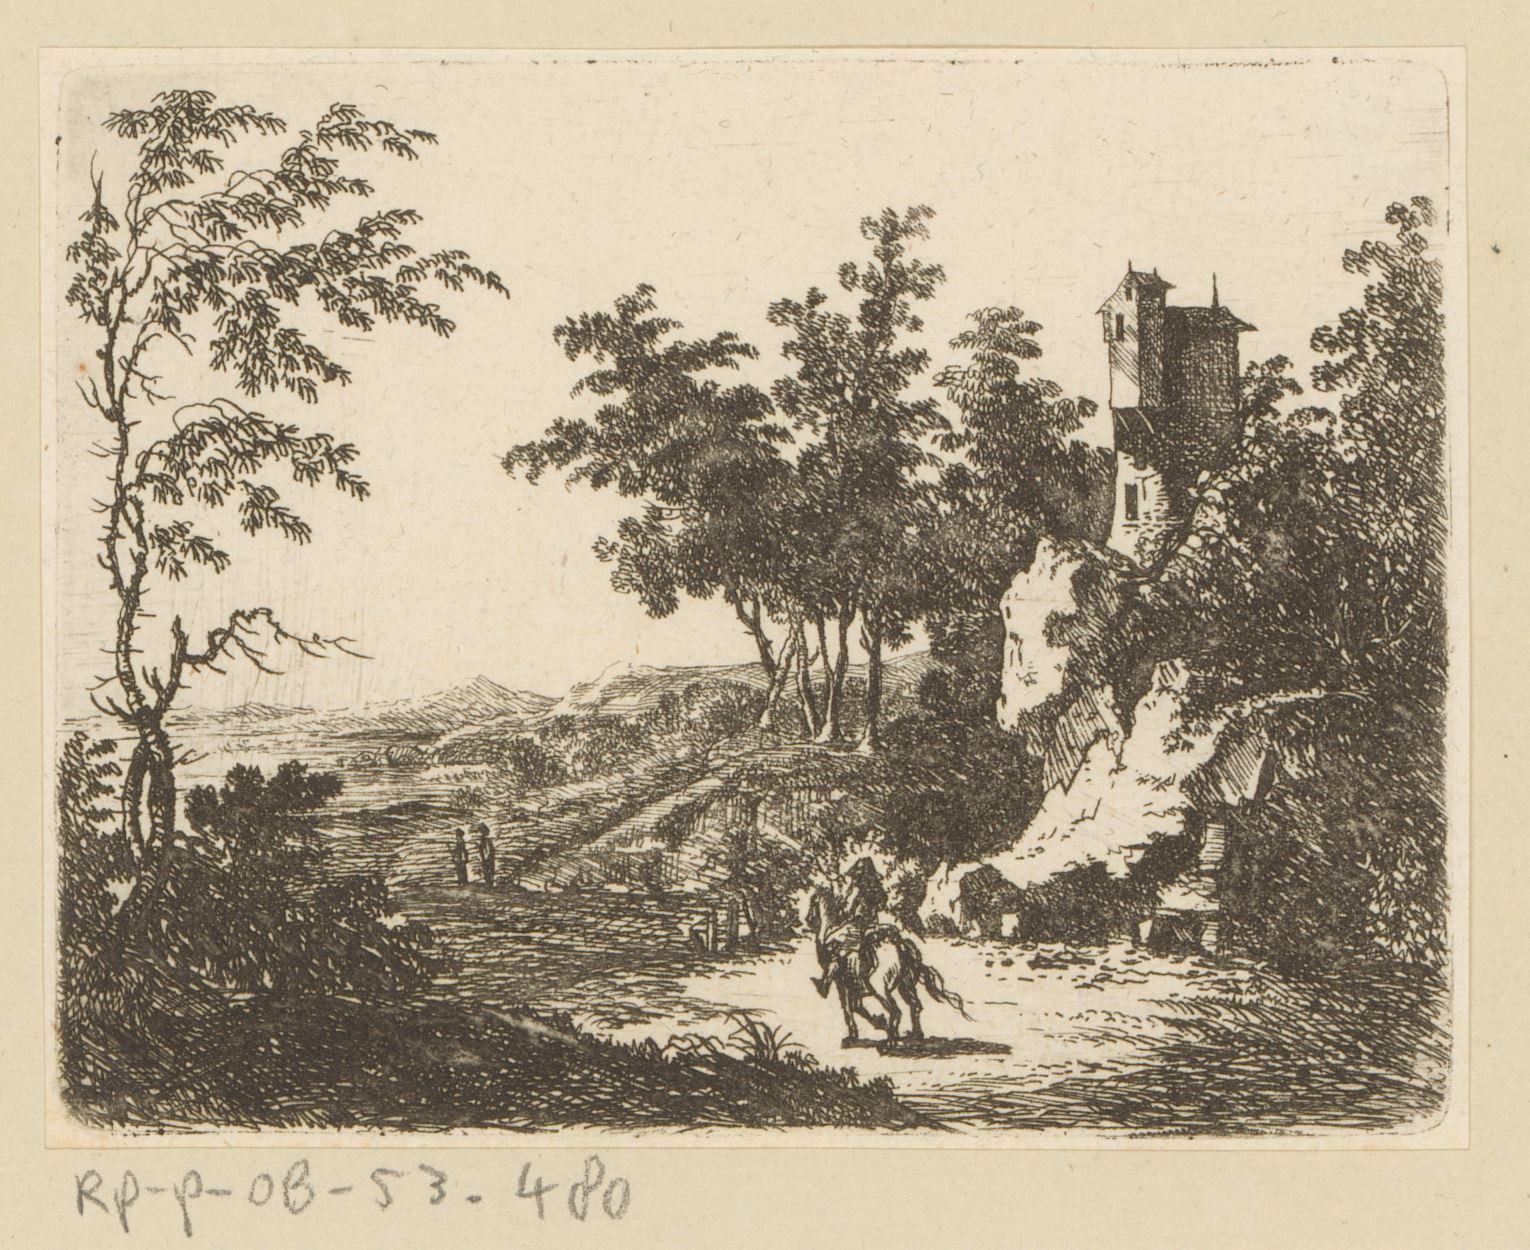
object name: print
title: Landschap met uitkijktoren op rots en ruiter op voorgrond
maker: johann andreas benjamin nothnagel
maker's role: print maker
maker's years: 1729-1804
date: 1739-1804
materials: paper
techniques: etching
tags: riding a horse, ass, or mule; rider, horseman, landscapes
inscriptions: collector's mark: Lugt 240